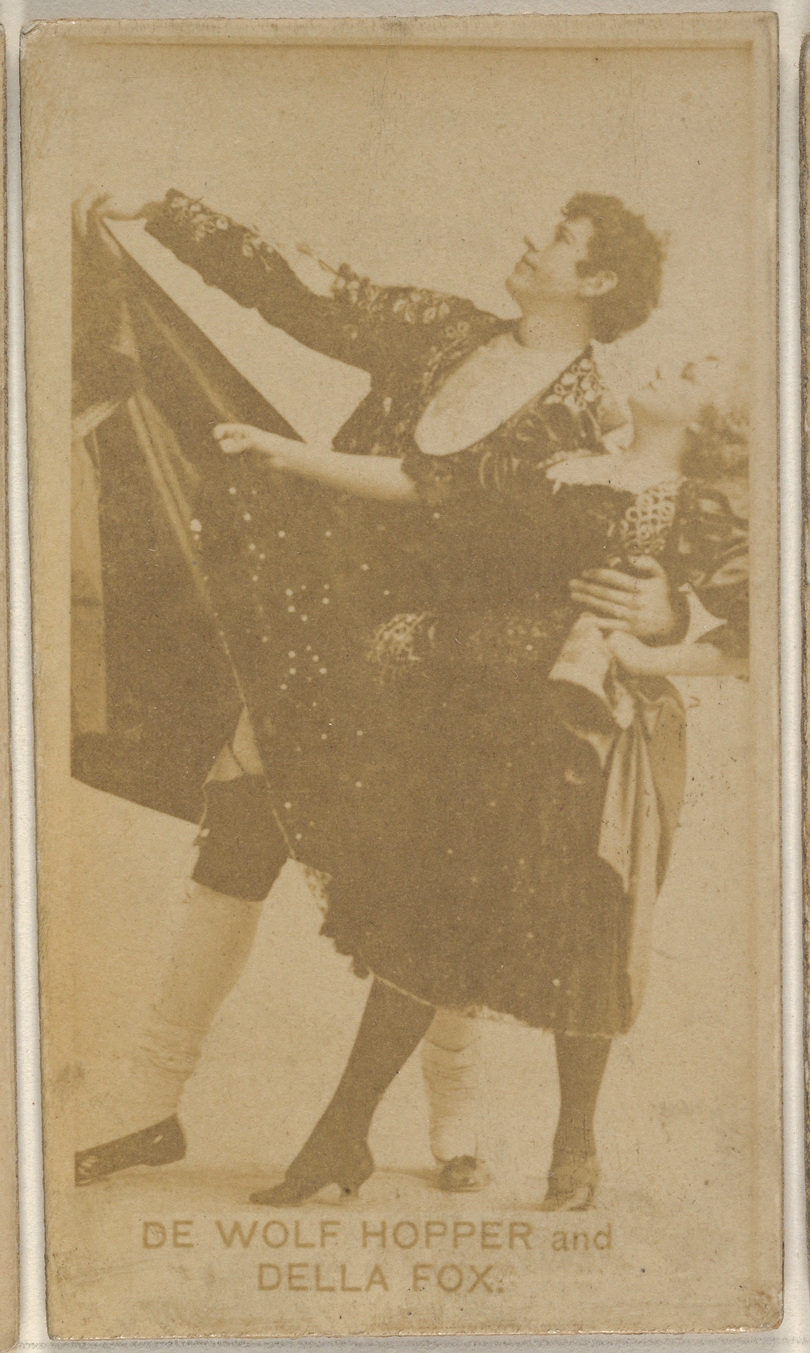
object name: photograph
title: De Wolf Hopper and Della Fox, from the Actors and Actresses series (N45, Type 8) for Virginia Brights Cigarettes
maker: allen & ginter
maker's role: publisher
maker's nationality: american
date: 1888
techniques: albumen silver print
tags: men,portraits,women,dancing,actresses